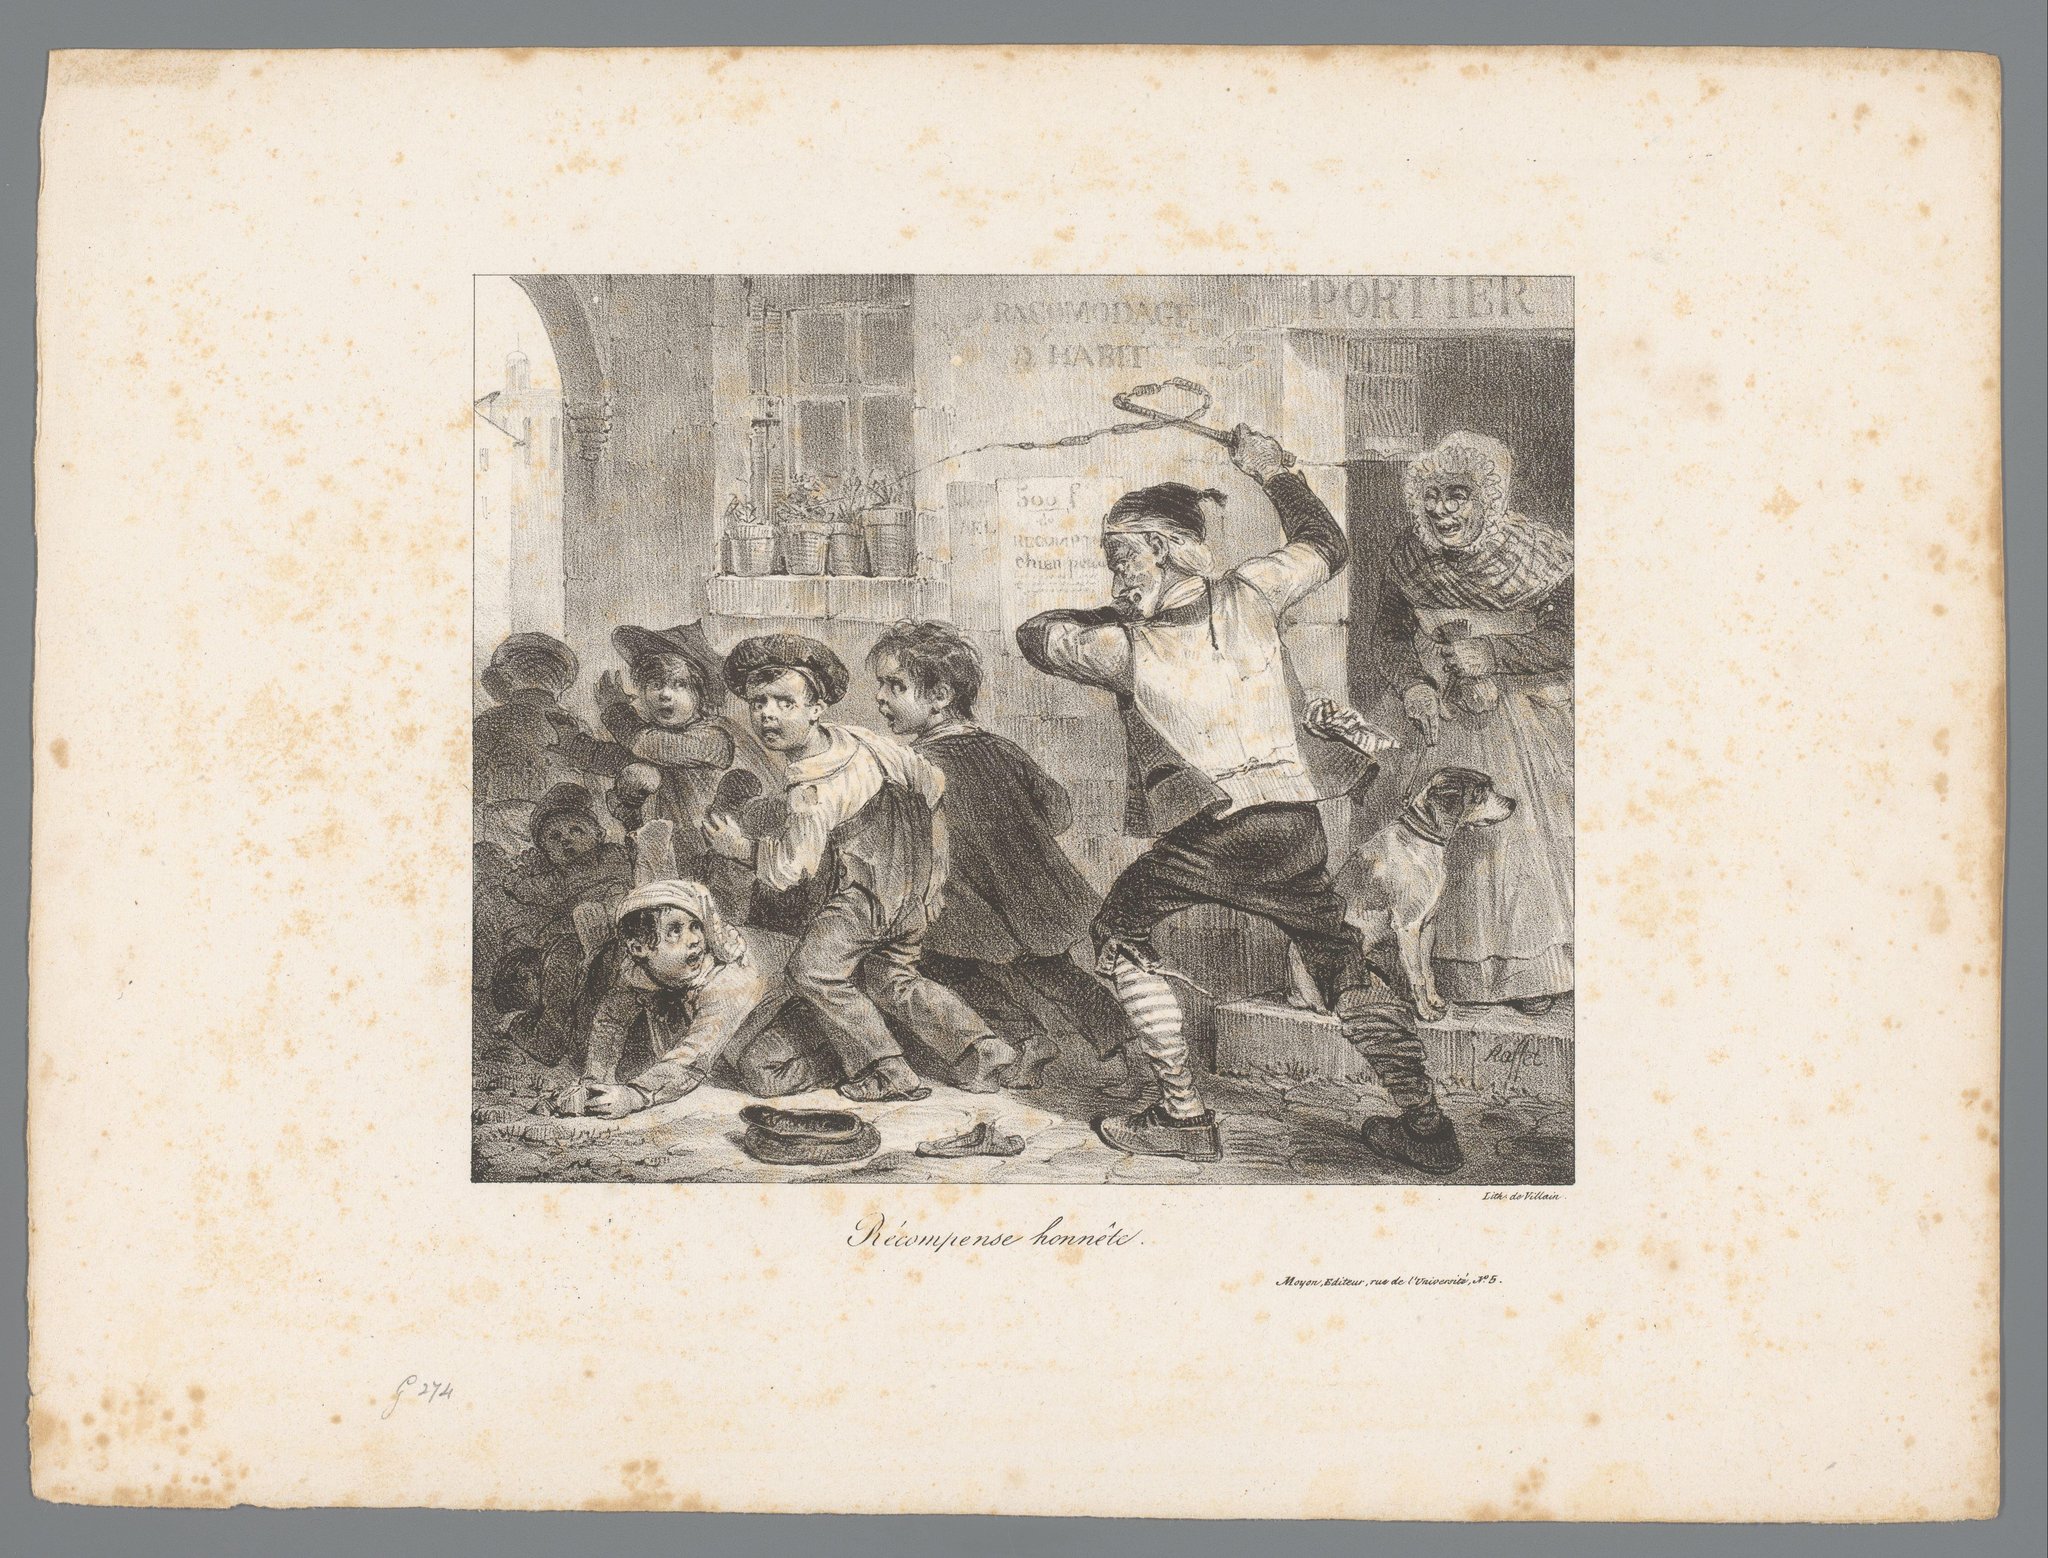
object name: print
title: Man jaagt kinderen weg met zweep, vrouw met zak geld en hond staan in de deuropening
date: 1827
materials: paper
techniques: lithograph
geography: paris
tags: purse, money-bag, adult woman, adult man, child, dog, whip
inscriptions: collector's mark: Lugt 964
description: Serie bestaat uit titelprent en tien prenten. Derde prent in de serie van elf prenten.